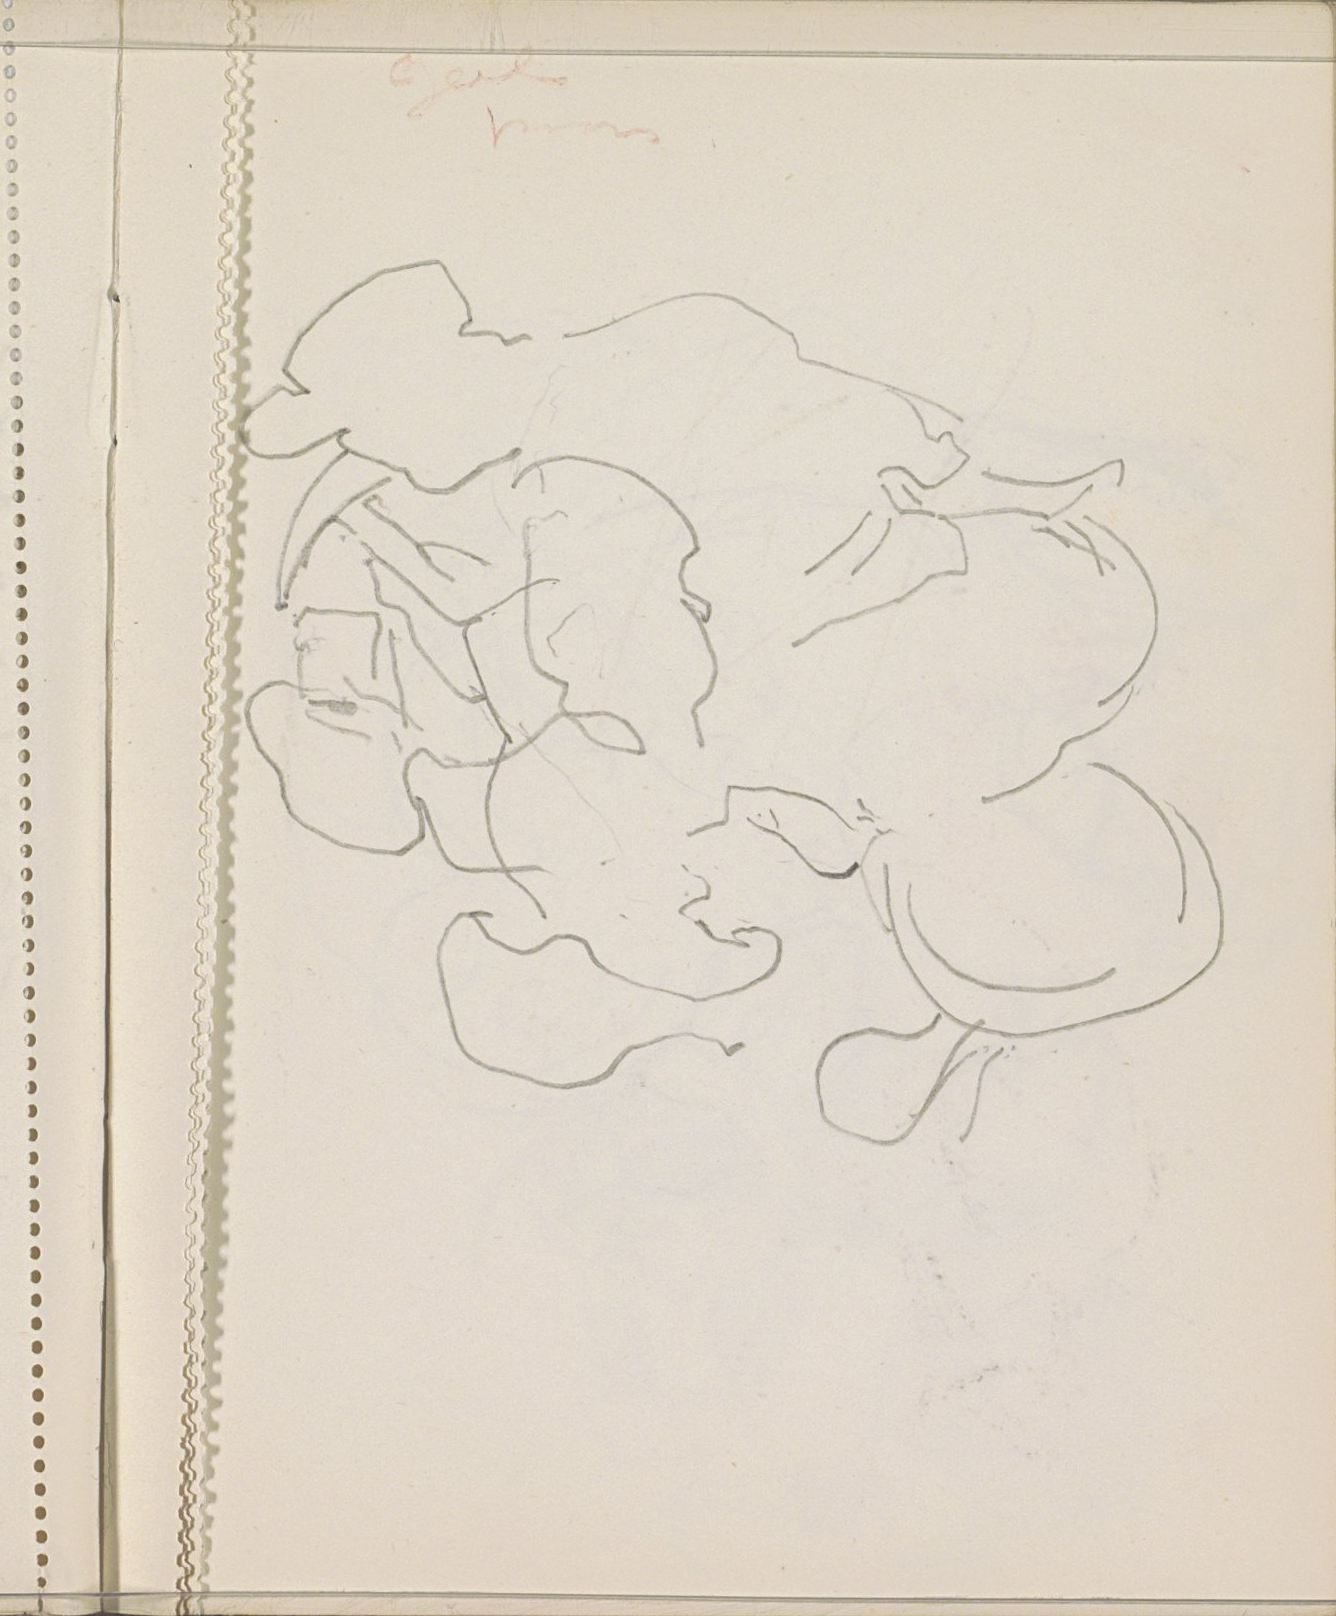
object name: sketchbook leaf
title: Knielende man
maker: reijer stolk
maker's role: draughtsman, print maker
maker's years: 1896-1945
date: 1906-1945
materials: paper, pencil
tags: kneeling figure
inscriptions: kleurnotitie, handgeschreven in rood kleurpotlood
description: Blad 21 recto uit een schetsboek met 42 bladen.